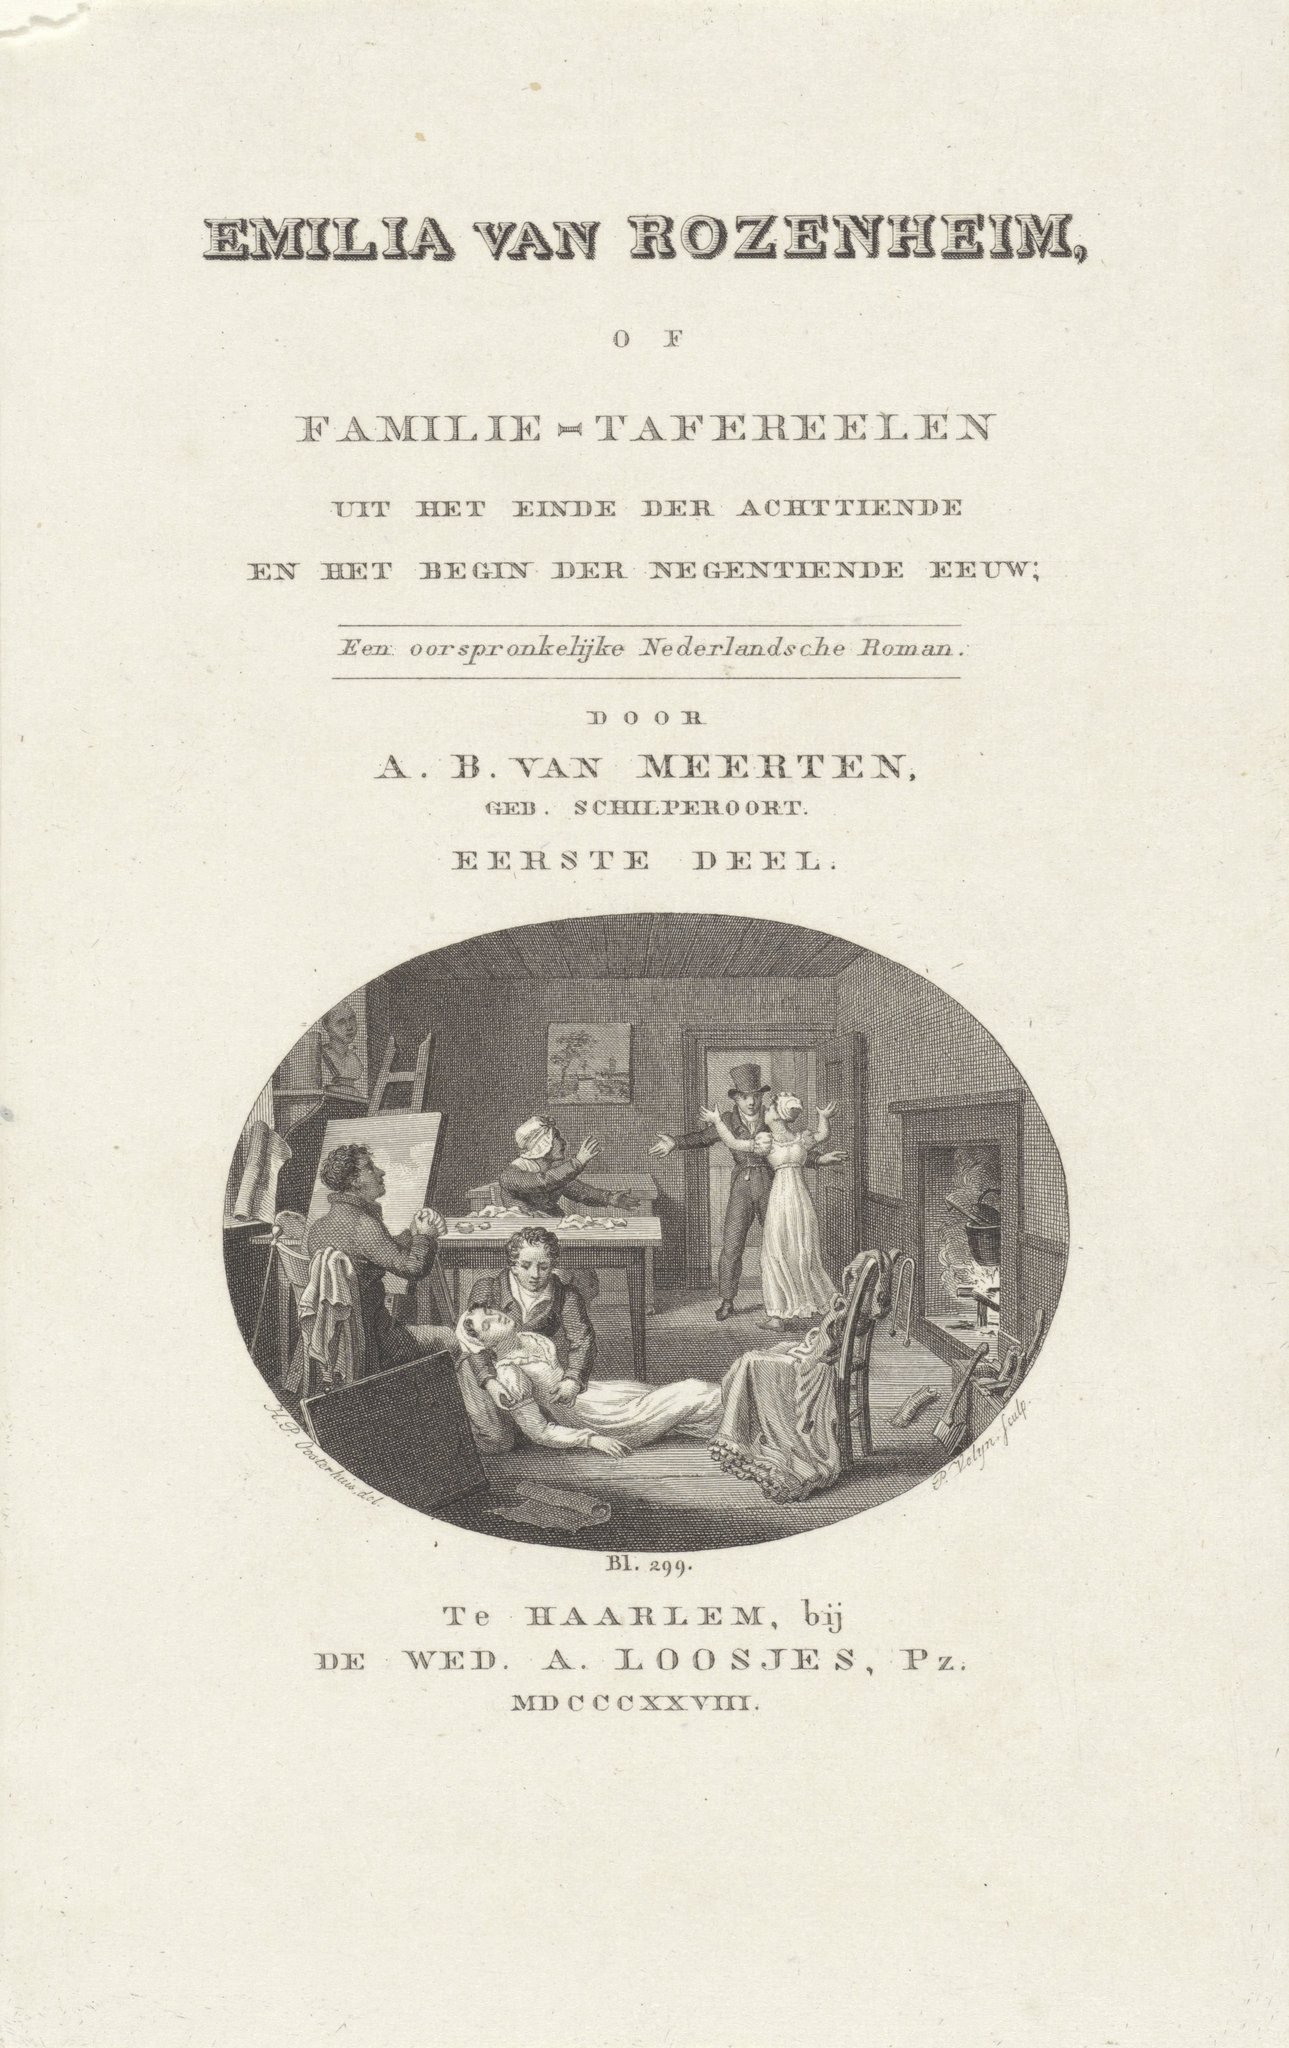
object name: print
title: Man in een deuropening wordt begroet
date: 1828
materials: paper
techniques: etching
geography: haarlem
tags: fainting, swooning, embracing each other, kissing, easel, recognizing, open fire, fire-place, stove (in kitchen)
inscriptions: collector's mark: Lugt 2228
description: Titelpagina voor: Meeteren, A.B. van, Emilia van Rozenheim, of Familie-tafereelen uit het einde der achttiende en het begin der negentiende eeuw: een oorspronkelijke Nederlandsche roman. Eerste deel. Haarlem: Wed. Adriaan Loosjes Pz, 1828.